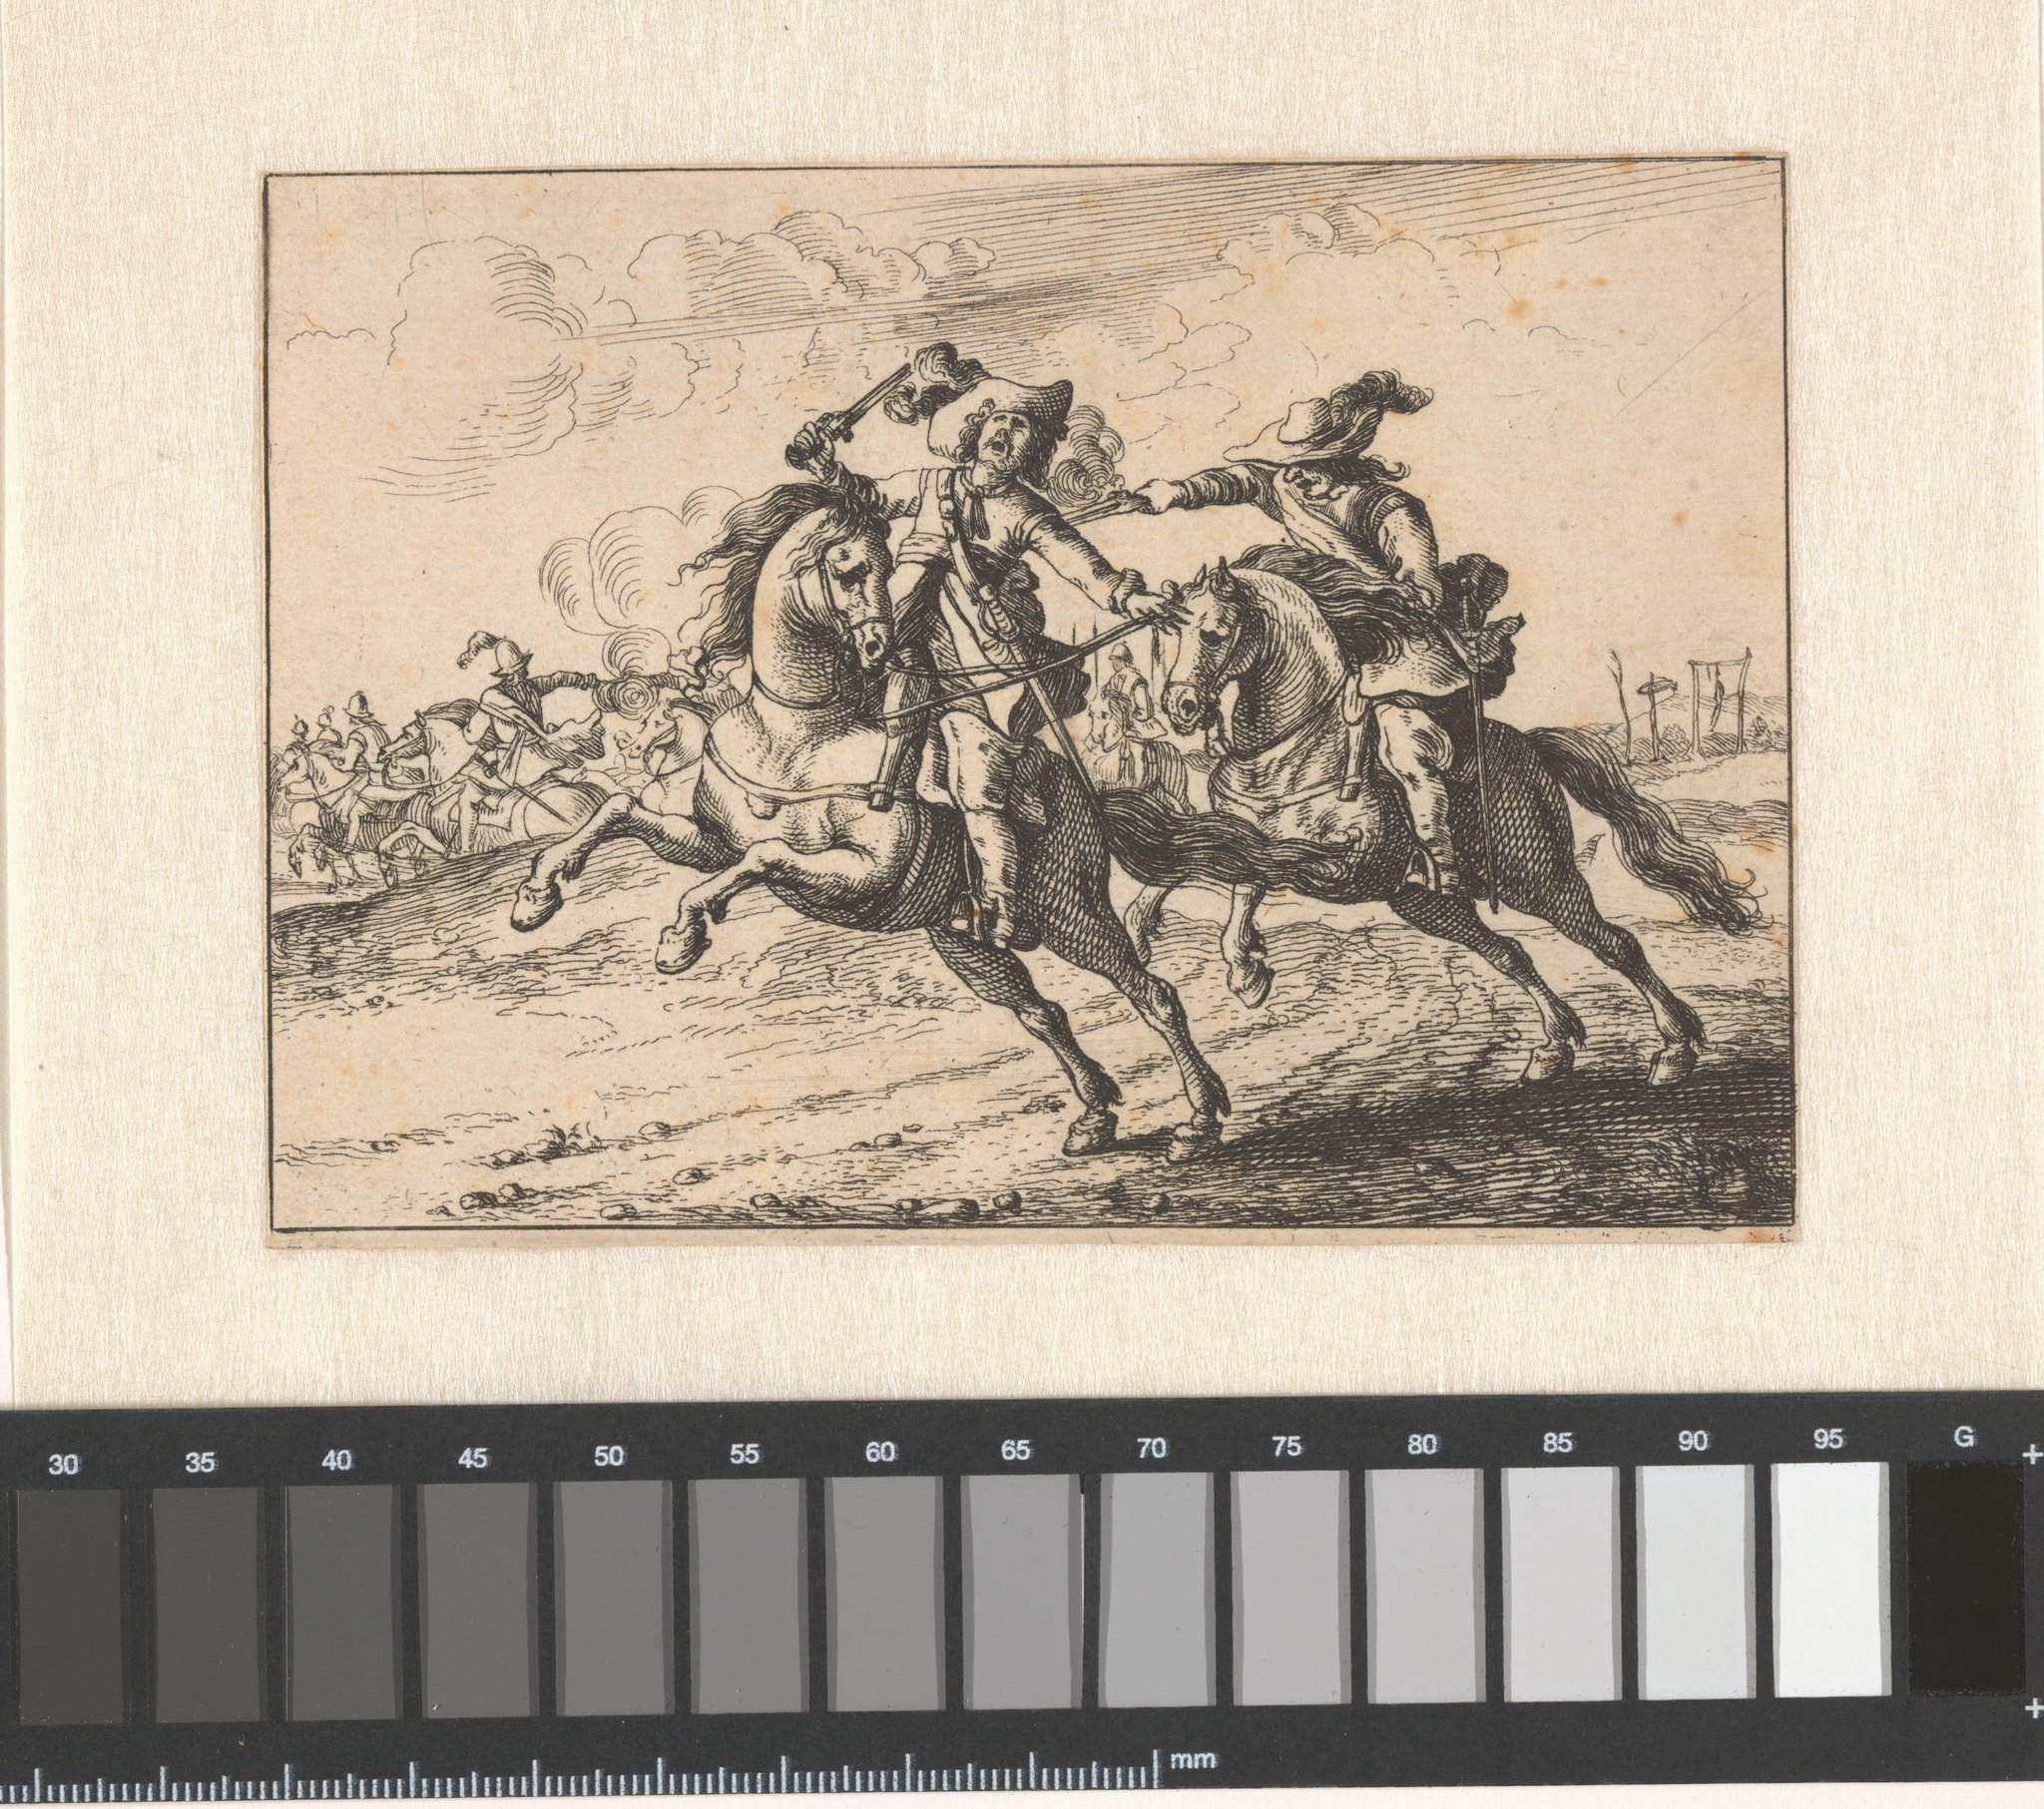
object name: print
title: Batailles et Rencontres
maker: theodorus van kessel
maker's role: print maker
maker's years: 1620-1660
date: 1654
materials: paper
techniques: etching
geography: antwerp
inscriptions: collector's mark: Lugt 972, collector's mark: Lugt 2228, collector's mark: Lugt 2760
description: Gevecht tussen ruiters met pistolen. Onderdeel van een serie van zes prenten over het leger van de landvoogd Leopold Willem, aartshertog van Oostenrijk.